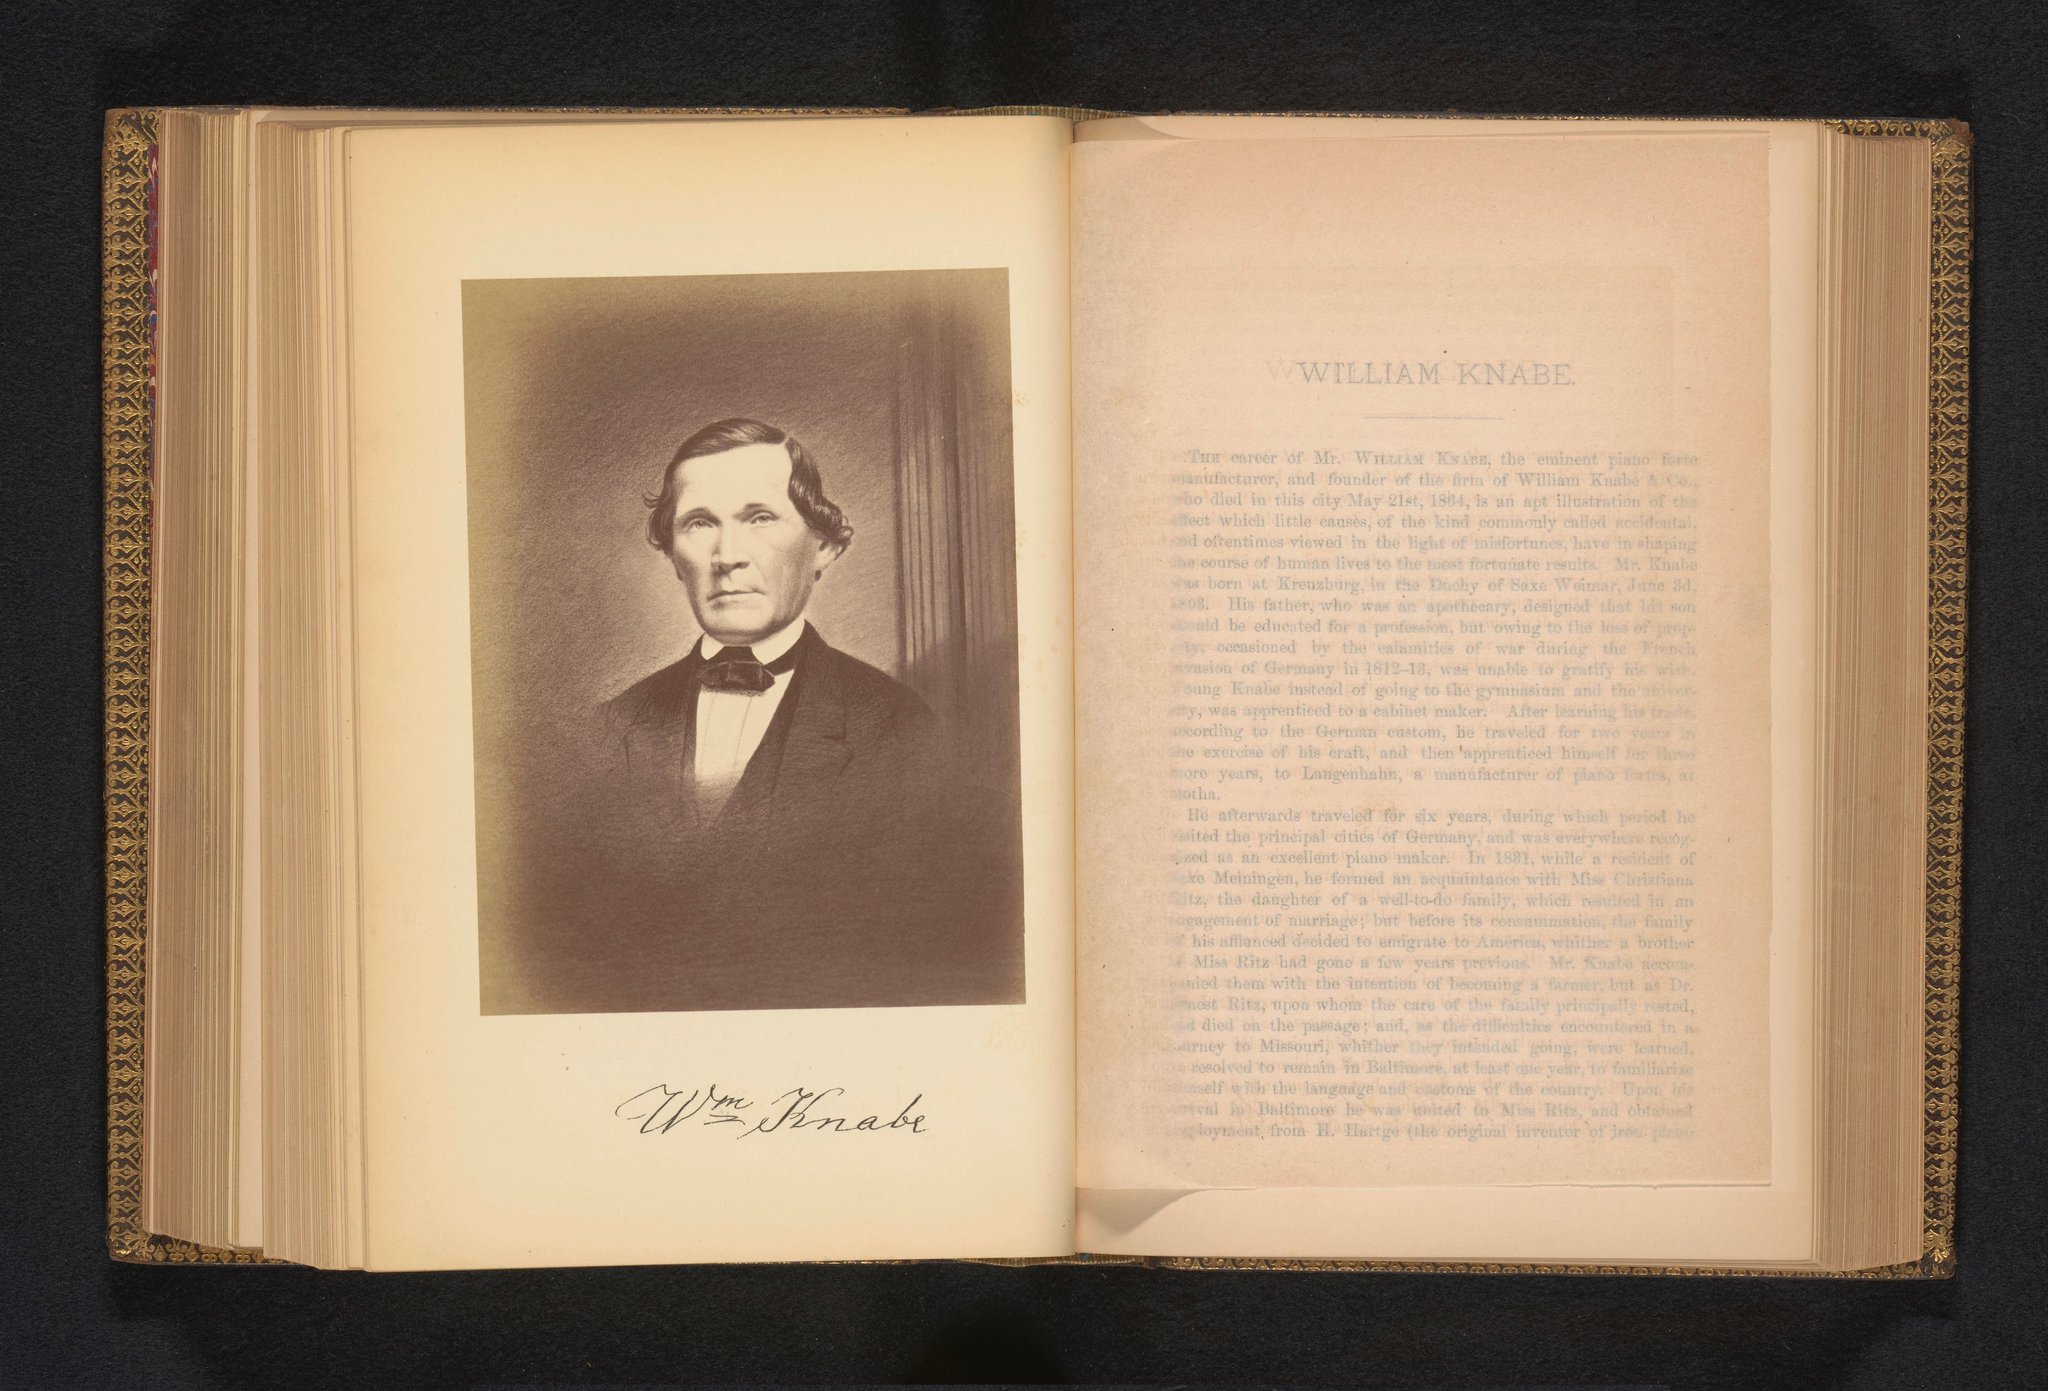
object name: reproduction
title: Fotoreproductie van een portret van William Knabe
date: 1866-1871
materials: photographic support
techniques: albumen print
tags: historical persons